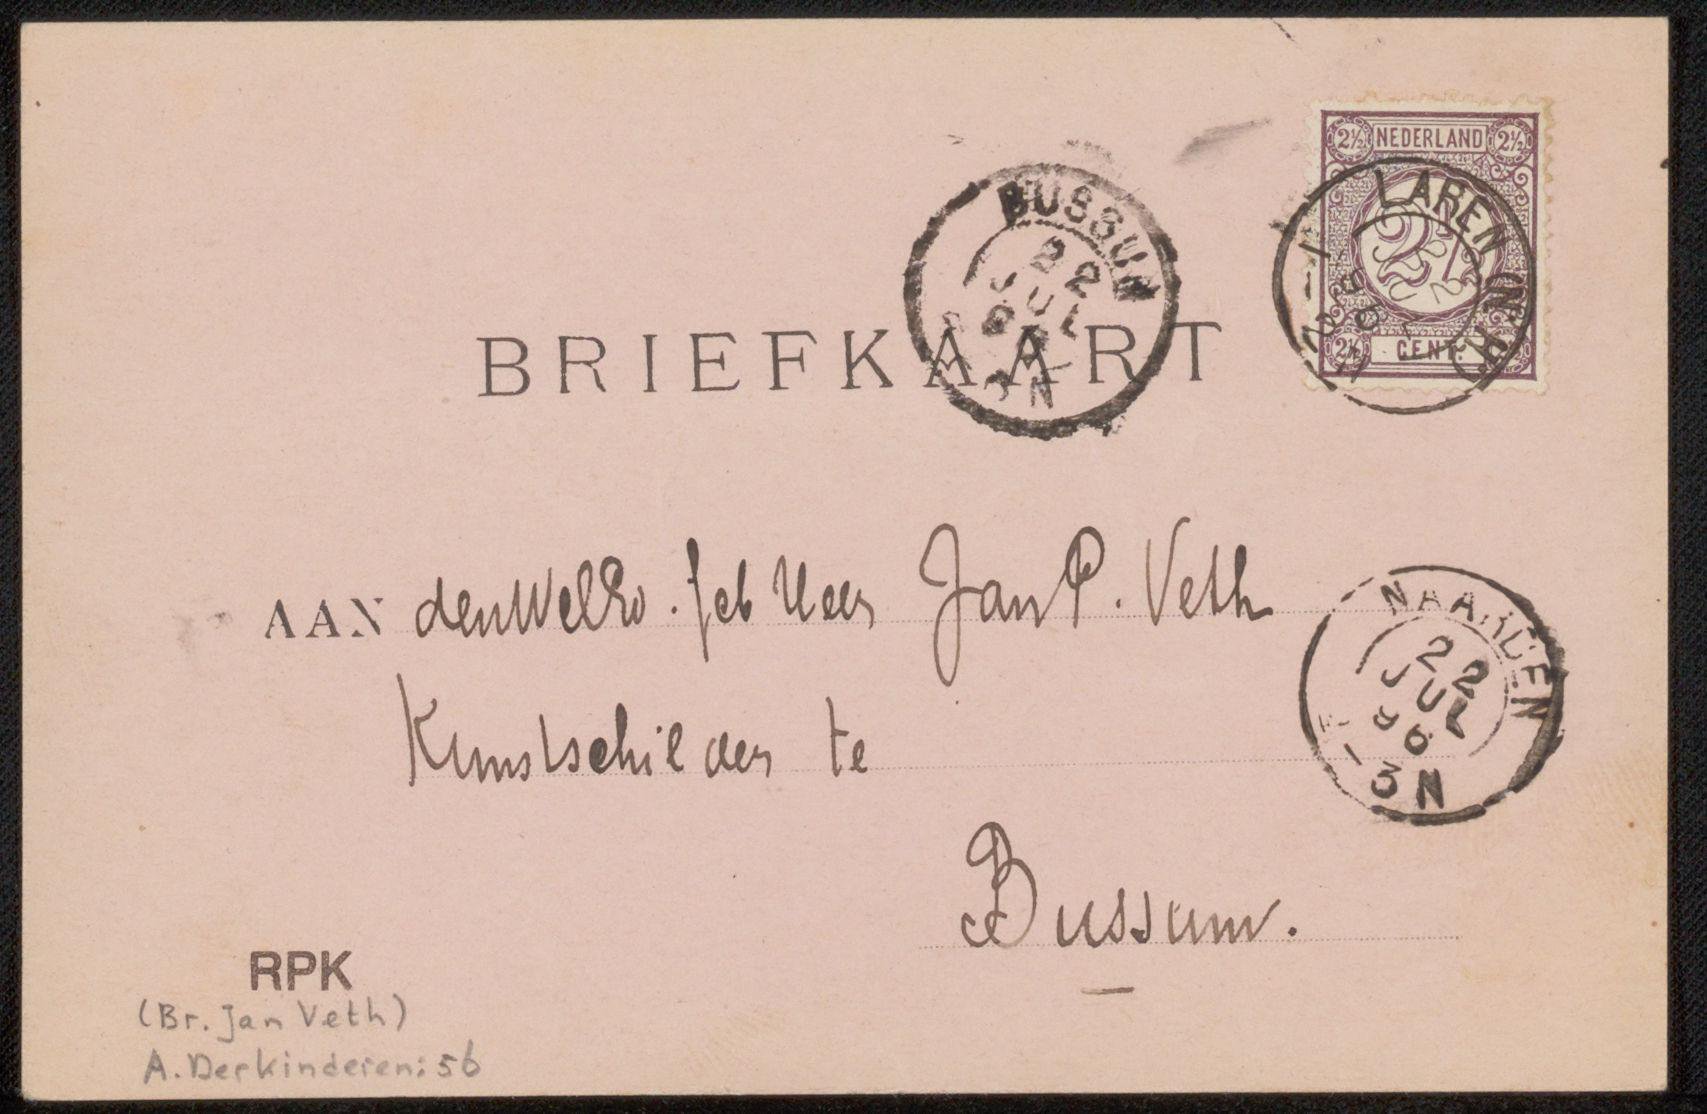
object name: postcard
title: Briefkaart aan Jan Veth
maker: antoon derkinderen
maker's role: draughtsman, painter, print maker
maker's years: 1859-1925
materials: cardboard, ink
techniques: pen, writing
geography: laren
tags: dordrecht, painter, print maker, draughtsman, designer, jan veth, printed matter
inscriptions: collector's mark: ‘RPK’